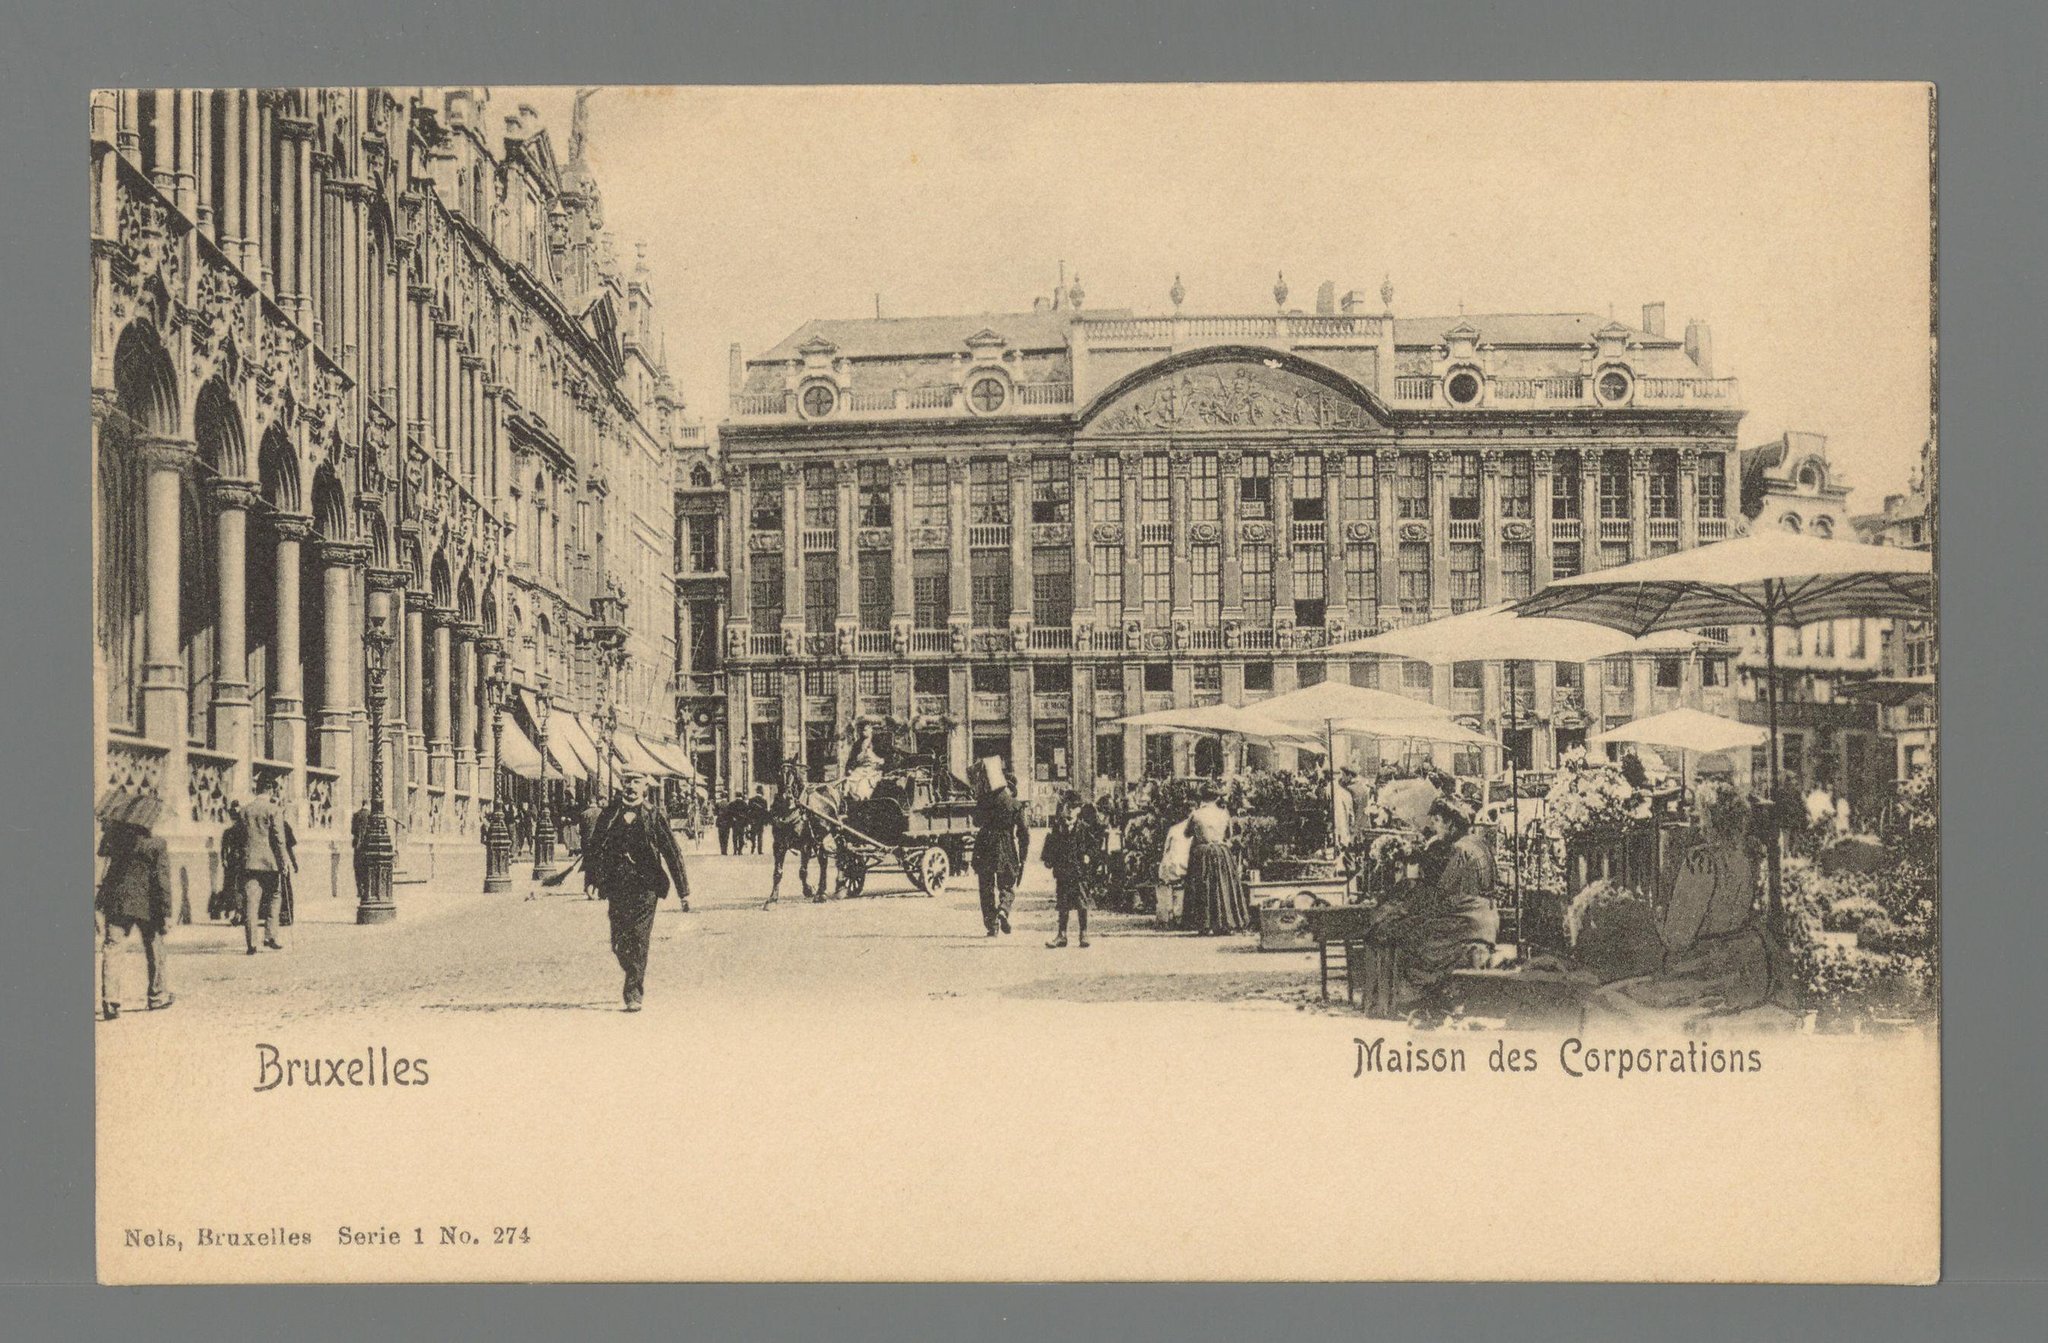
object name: photomechanical print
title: Bruxelles. Maisons des Corporations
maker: Anonymous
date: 1898-1906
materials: cardboard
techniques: photograph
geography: brussels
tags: square, place, circus, etc., market, city-view, and landscape with man-made constructions (+ city(-scape) with figures, staffage)